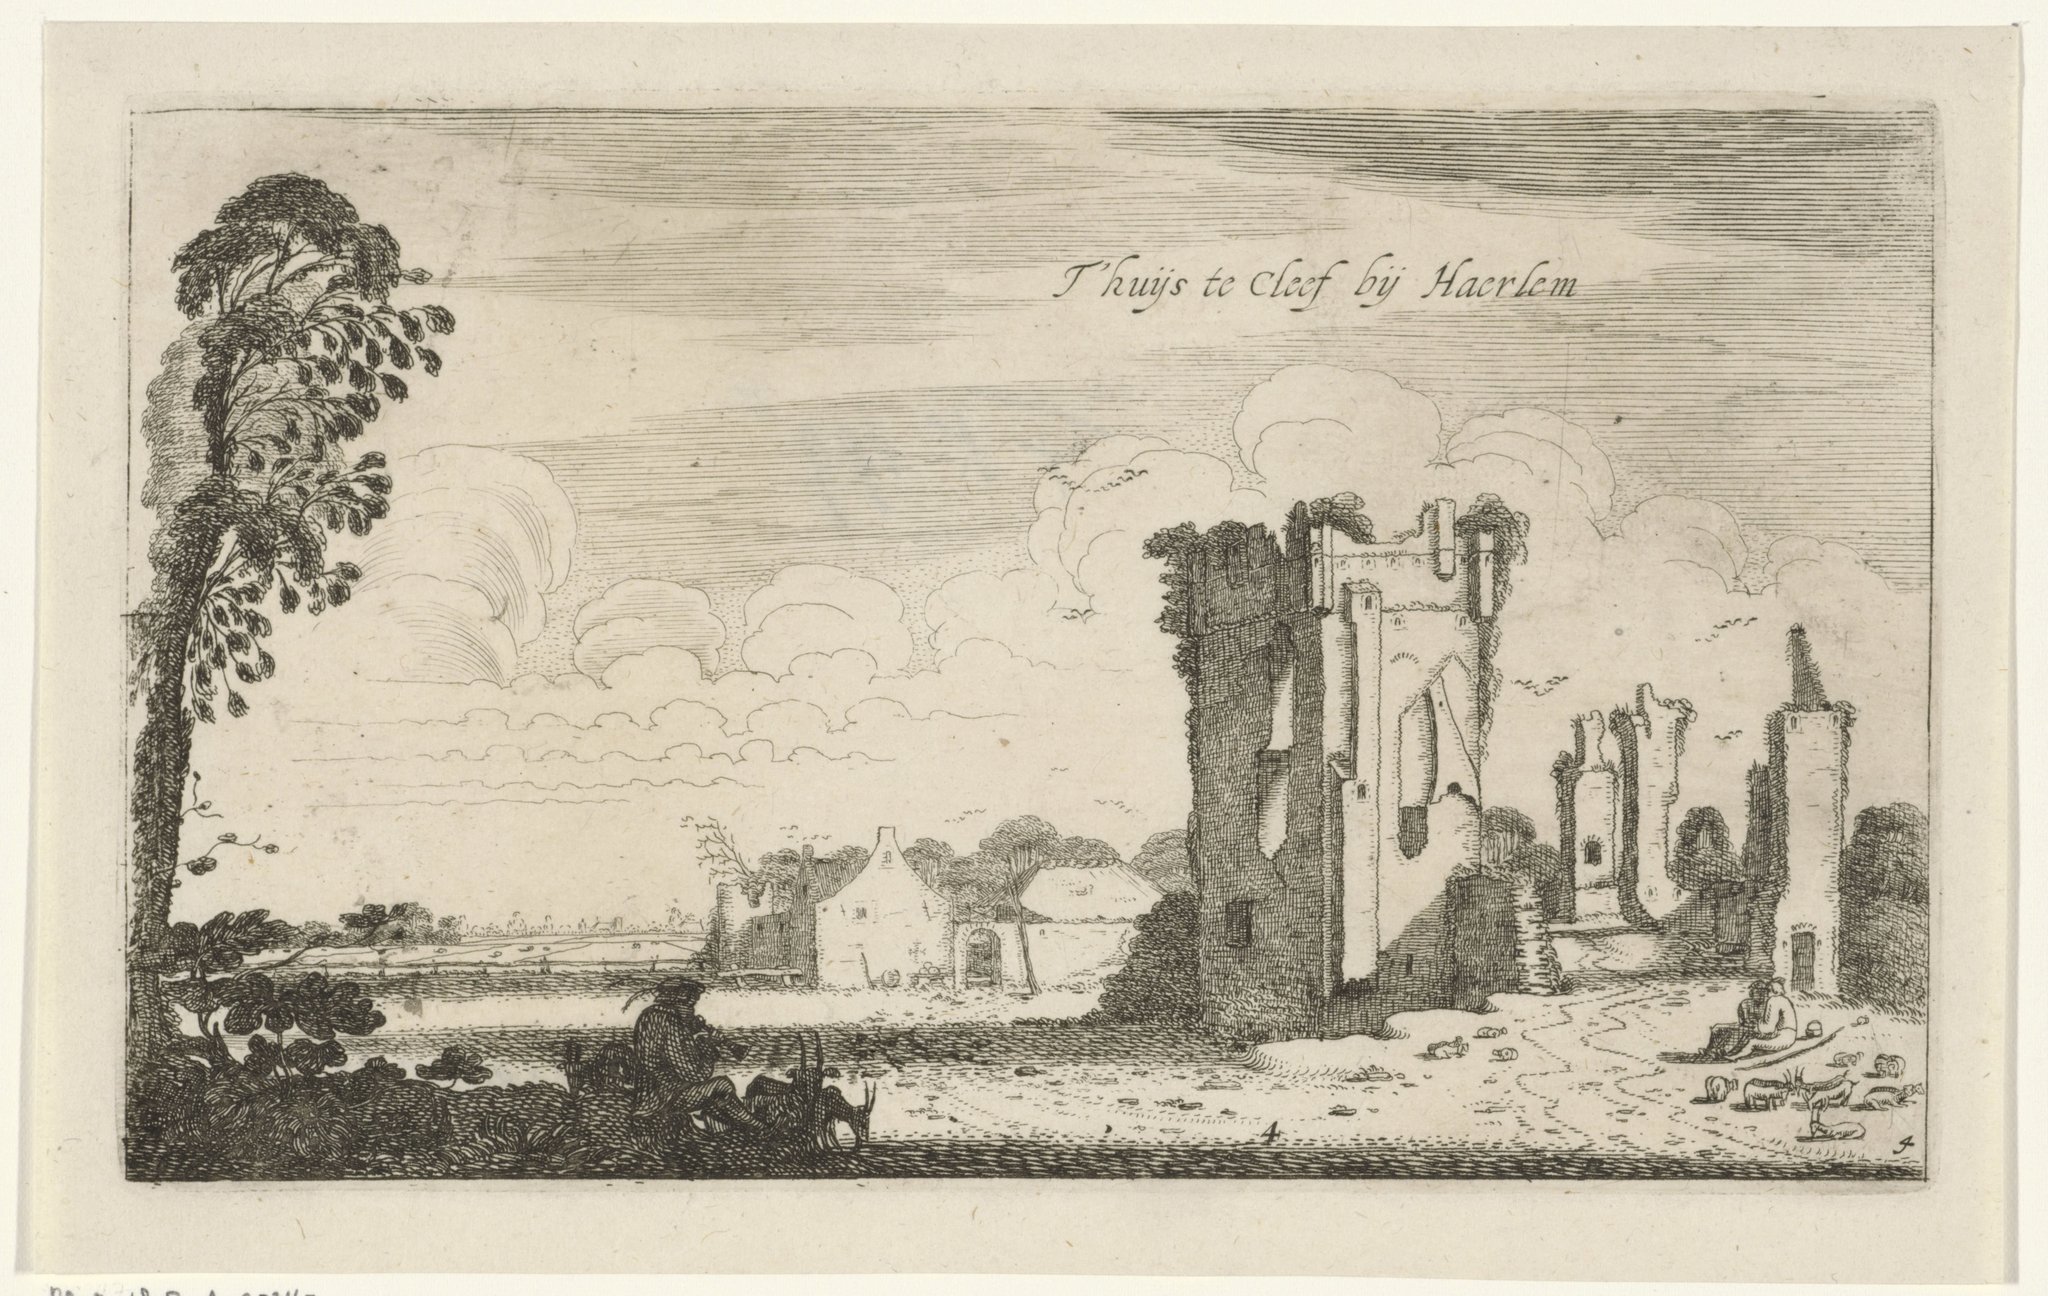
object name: print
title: Kastelen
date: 1616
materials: paper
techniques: etching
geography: northern netherlands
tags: landscape with ruins, landscape with tower or castle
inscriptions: collector's mark: Lugt 964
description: Ruïne van het Huis ter Kleef, op de voorgrond links een herder met bokken. Rechts twee converserende figuren. Vierde prent uit een serie van zes.